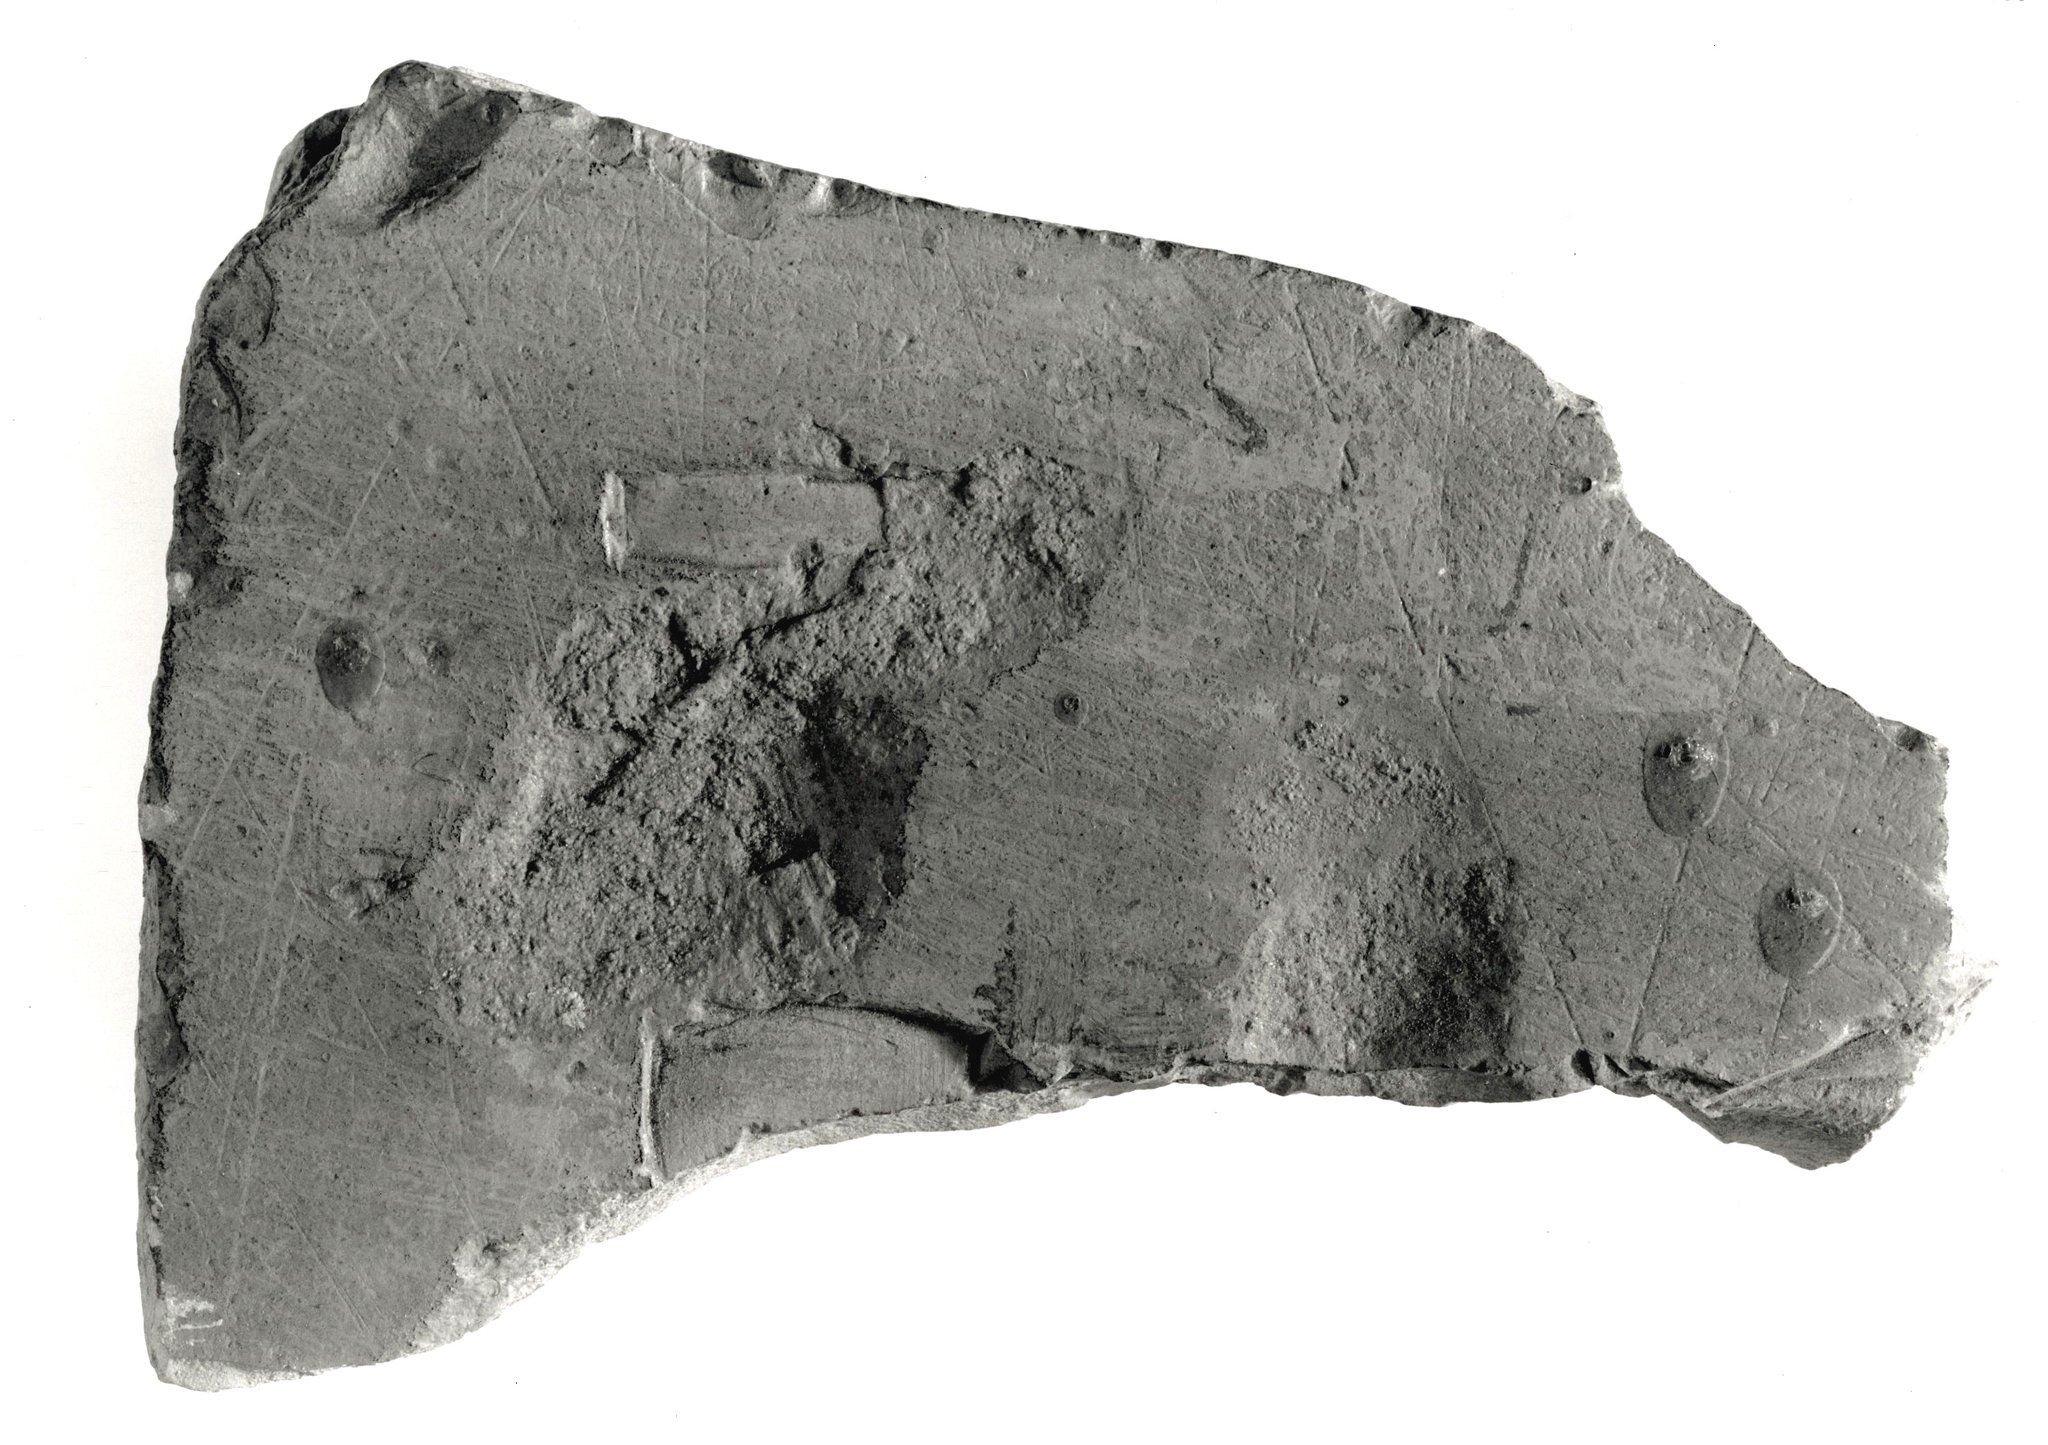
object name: relief, tomb of nespekashuty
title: Sunk relief fragment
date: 664-610 BCE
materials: limestone, mortar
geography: egypt